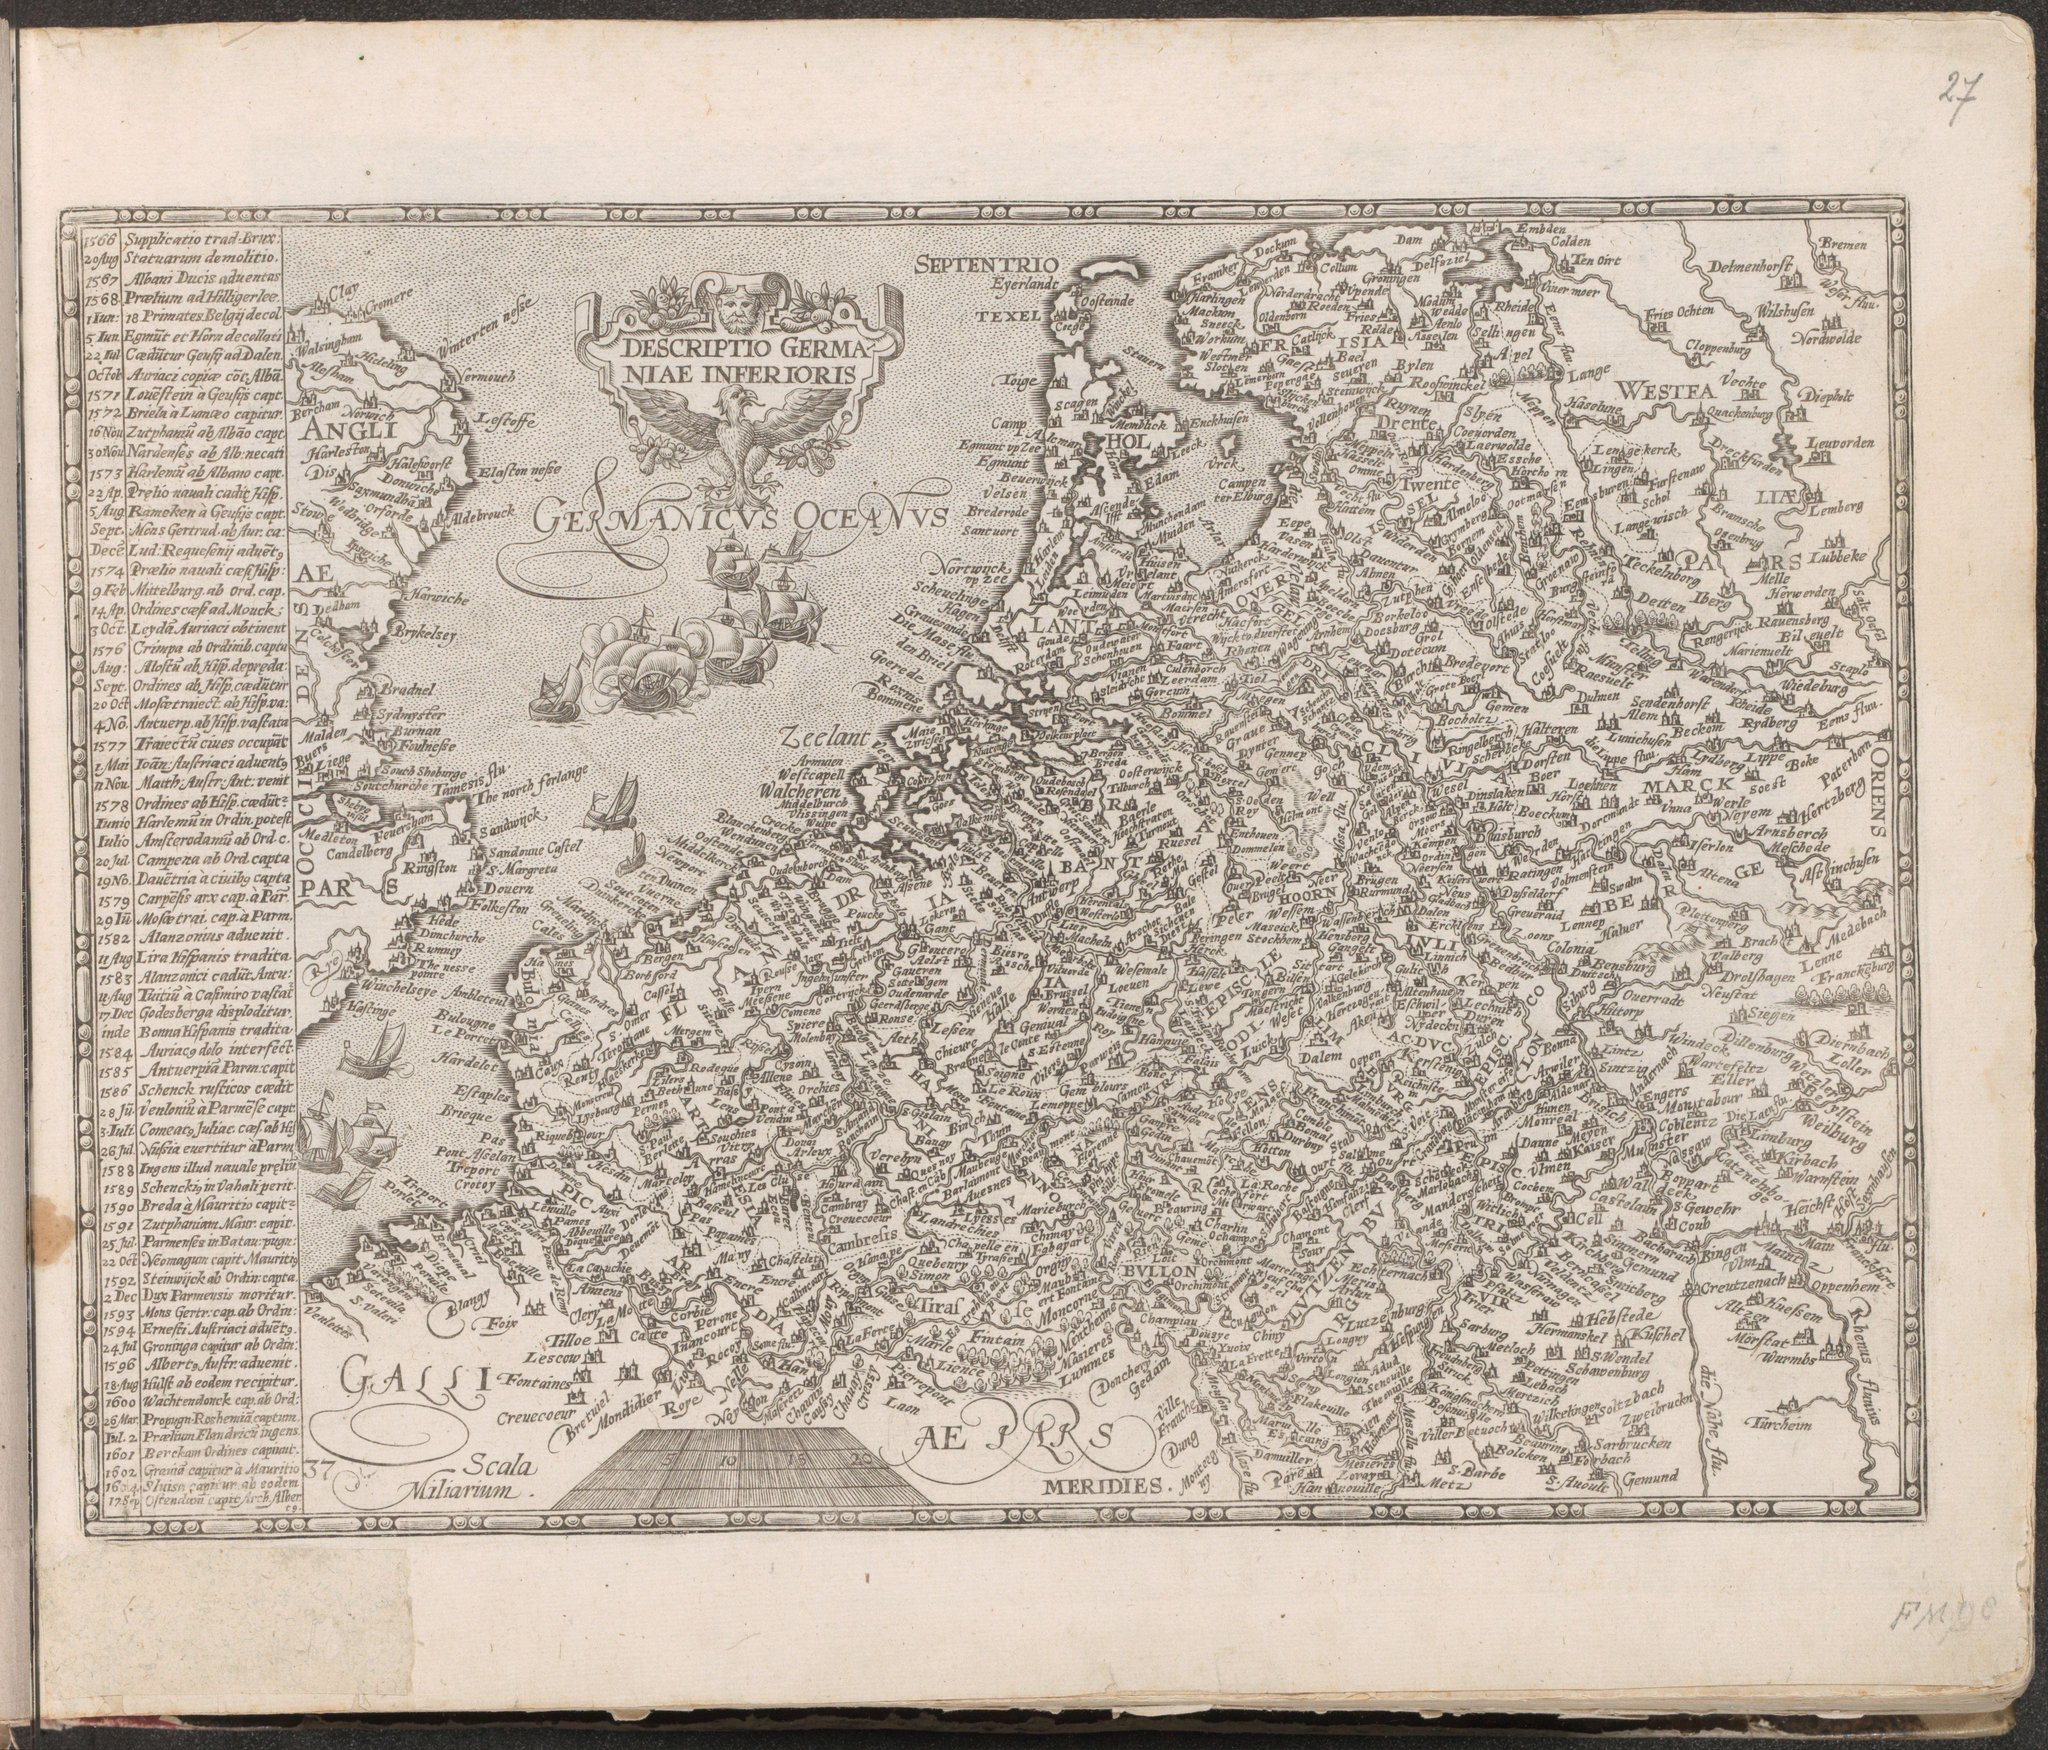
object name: album leaf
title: Kaart van de Nederlanden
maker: frans hogenberg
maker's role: print maker, publisher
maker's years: 1538-1590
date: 1604-1605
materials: paper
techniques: engraving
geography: cologne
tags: maps of separate countries or regions, netherlands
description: Kaart van de Nederlanden. Met aan de linker zijde een lijst van de belangrijkste gebeurtenissen in de jaren 1566-1604, in het Latijn. Linksonder genummerd: 37. De prent maakt deel uit van een album.